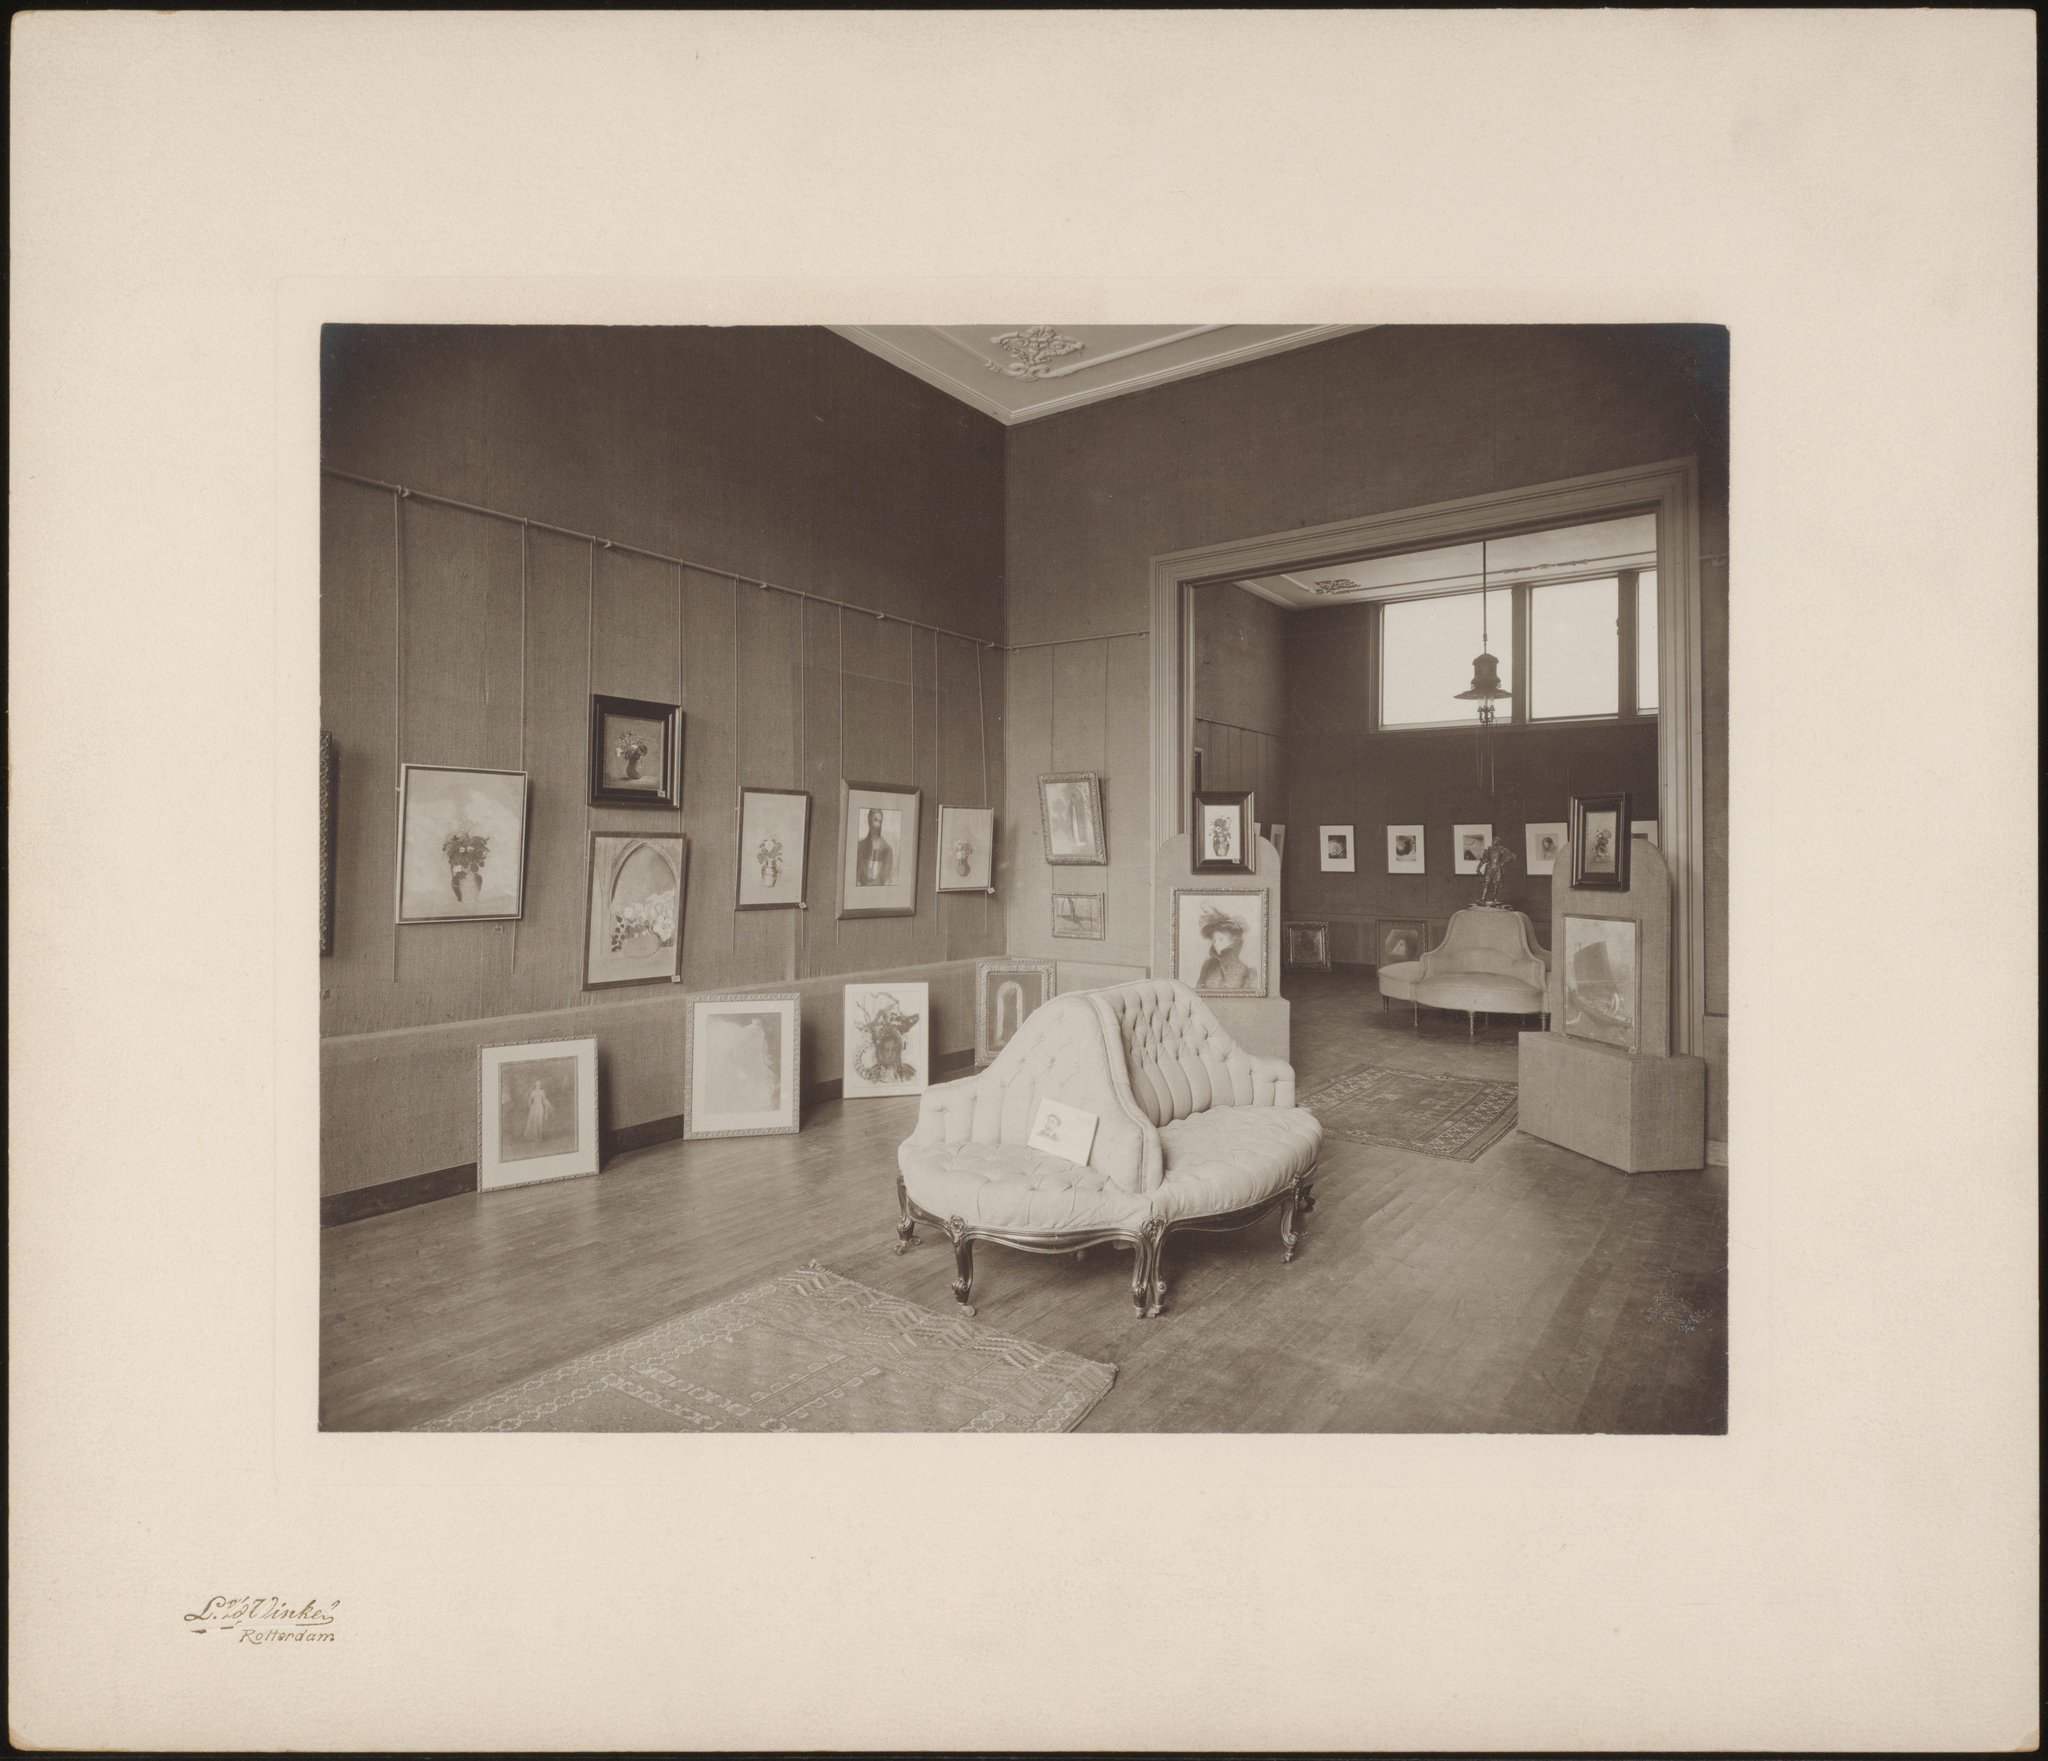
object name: photograph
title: Interieur van kunsthandel Reckers tijdens de Redon-expositie van 1907, Rotterdam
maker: lodewijk van de winkel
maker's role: fotograaf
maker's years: 1856-1919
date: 1905-1907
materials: cardboard, paper, photographic support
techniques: gelatin silver print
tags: exhibition ~ art